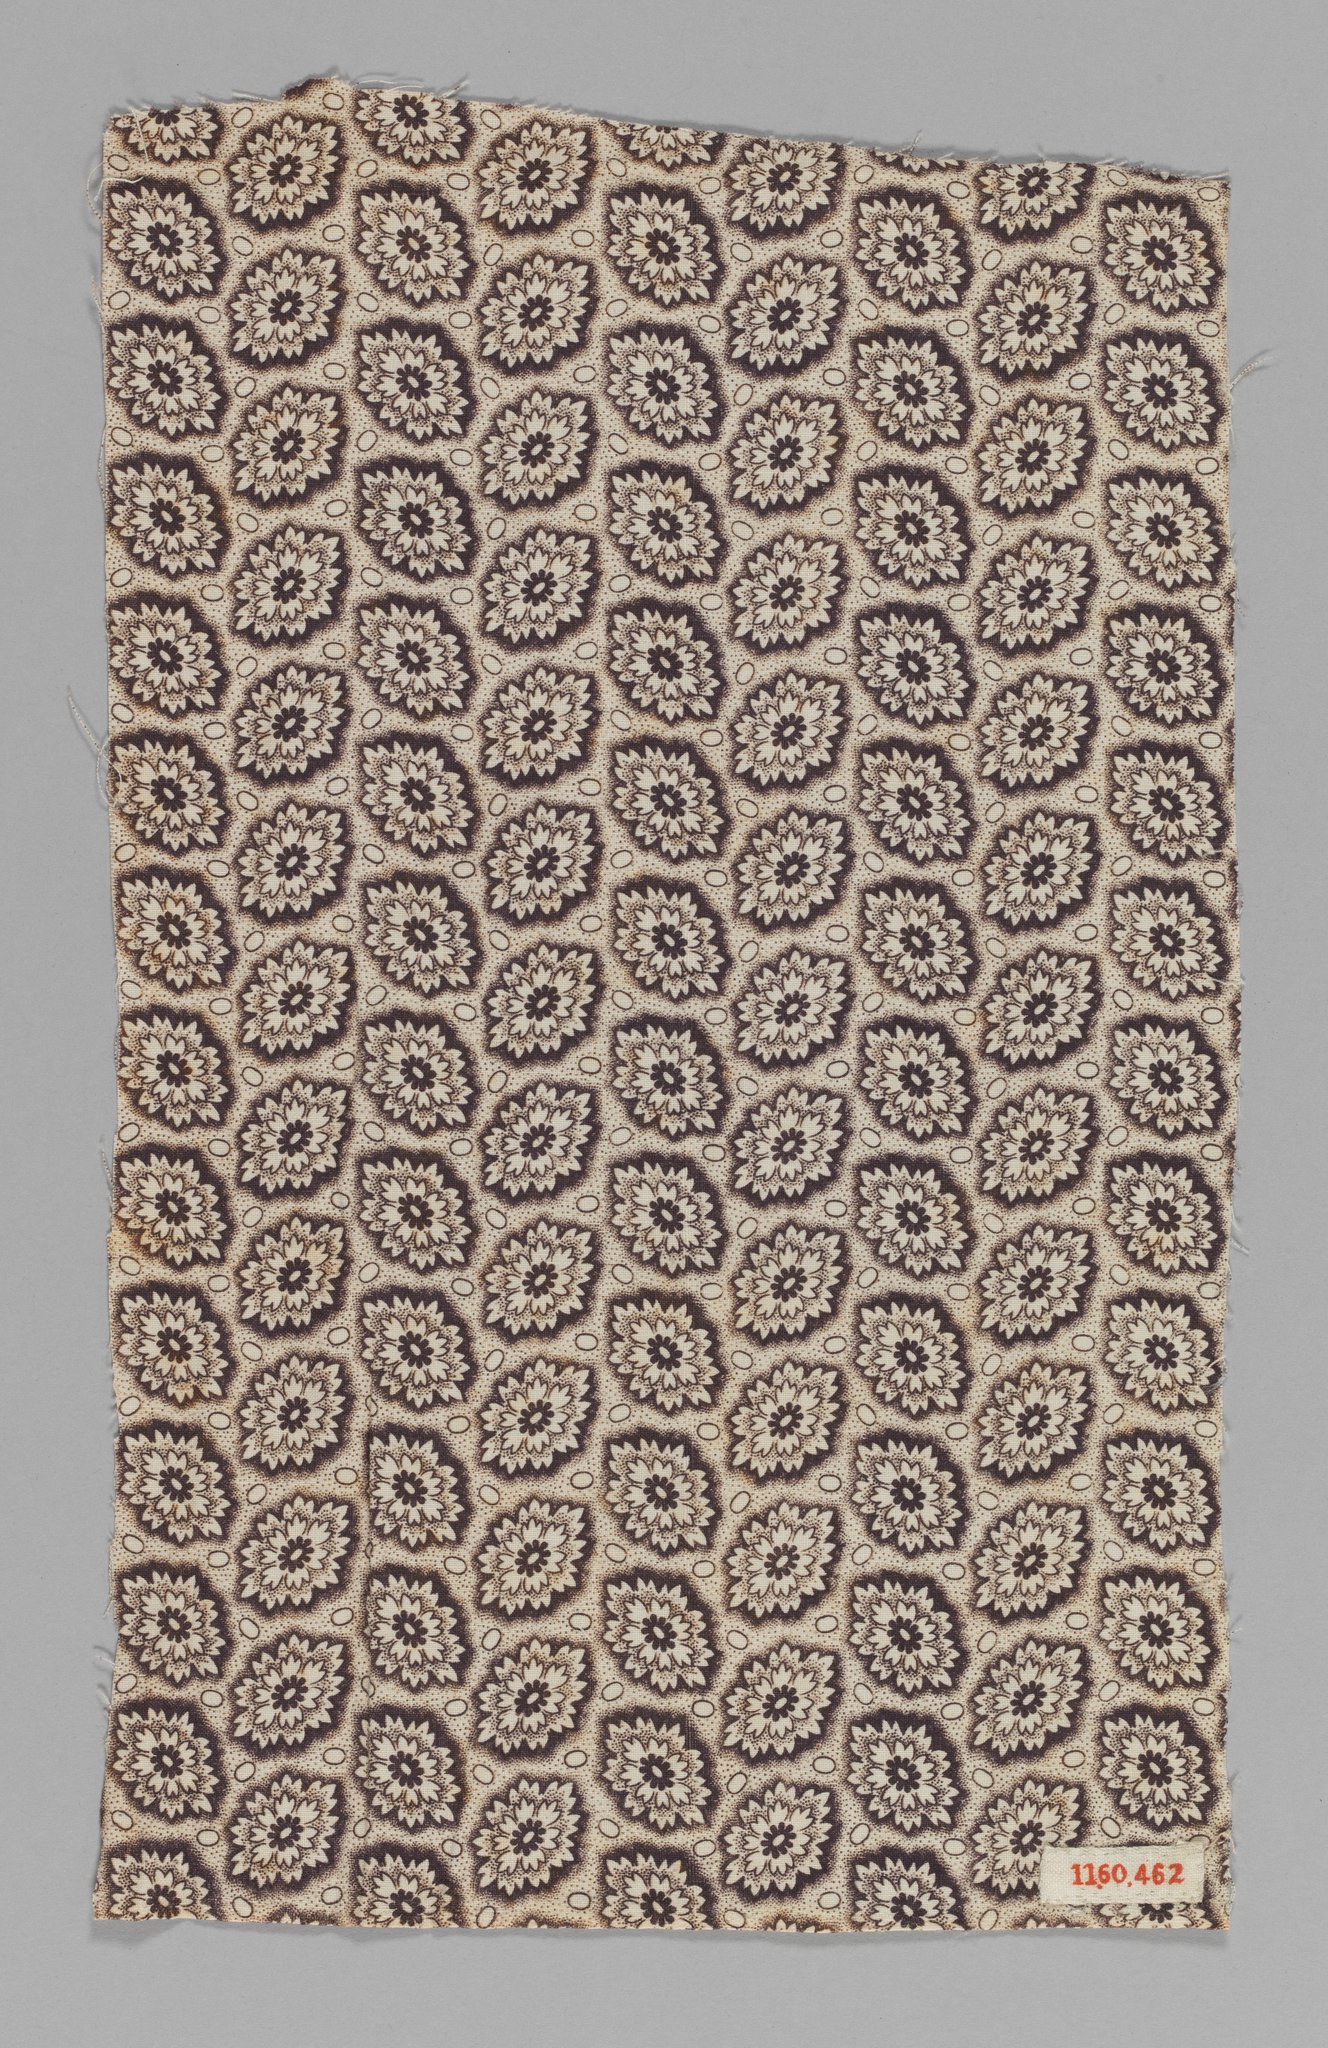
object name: piece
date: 1801-1900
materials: cotton